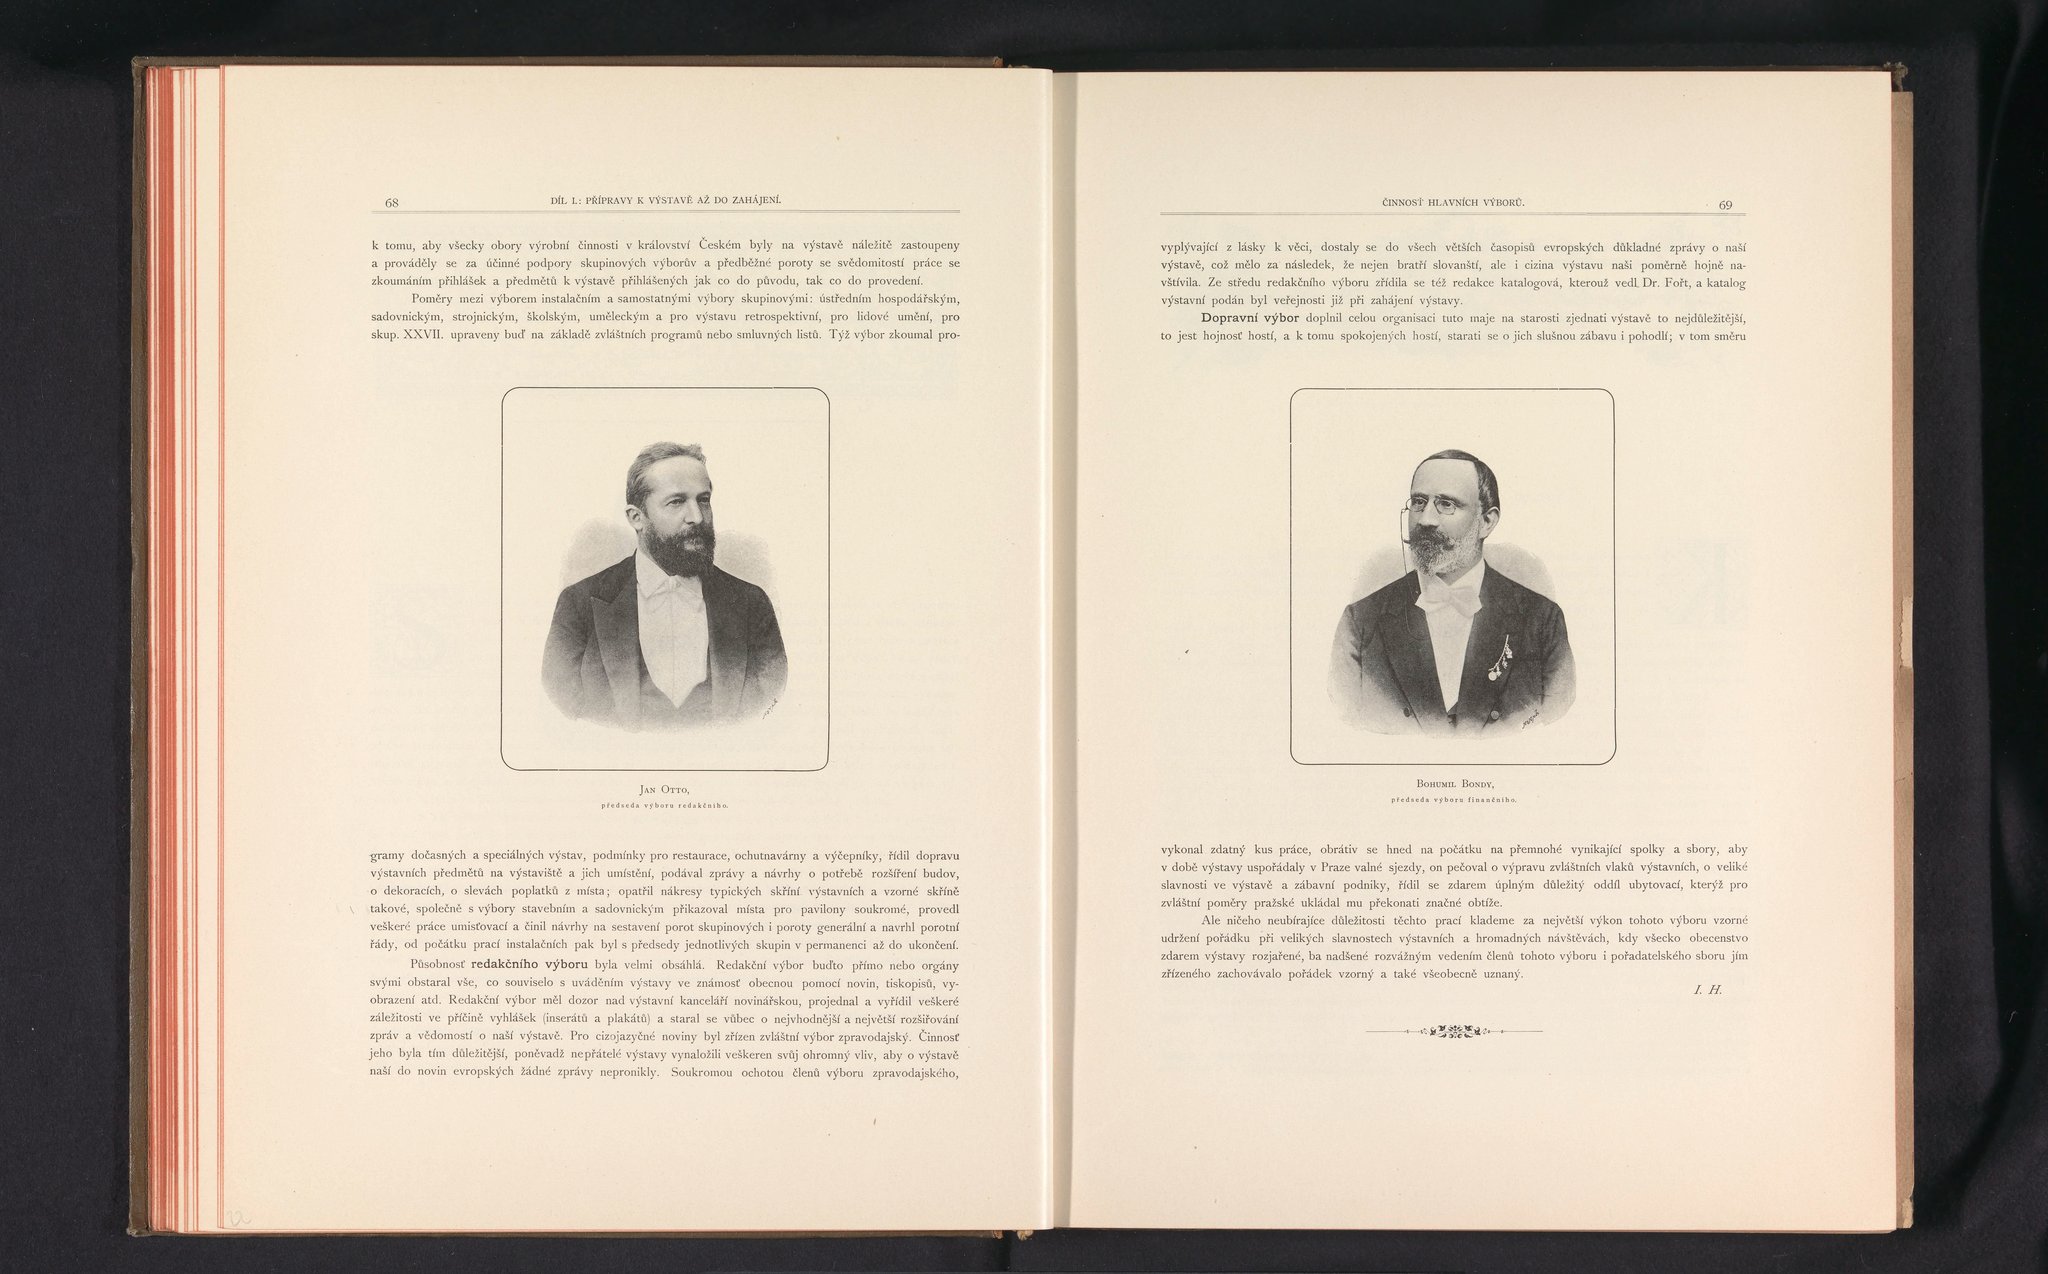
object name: page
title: Bohumil Bondy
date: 1888-1893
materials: paper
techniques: autotype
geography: prague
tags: adult man